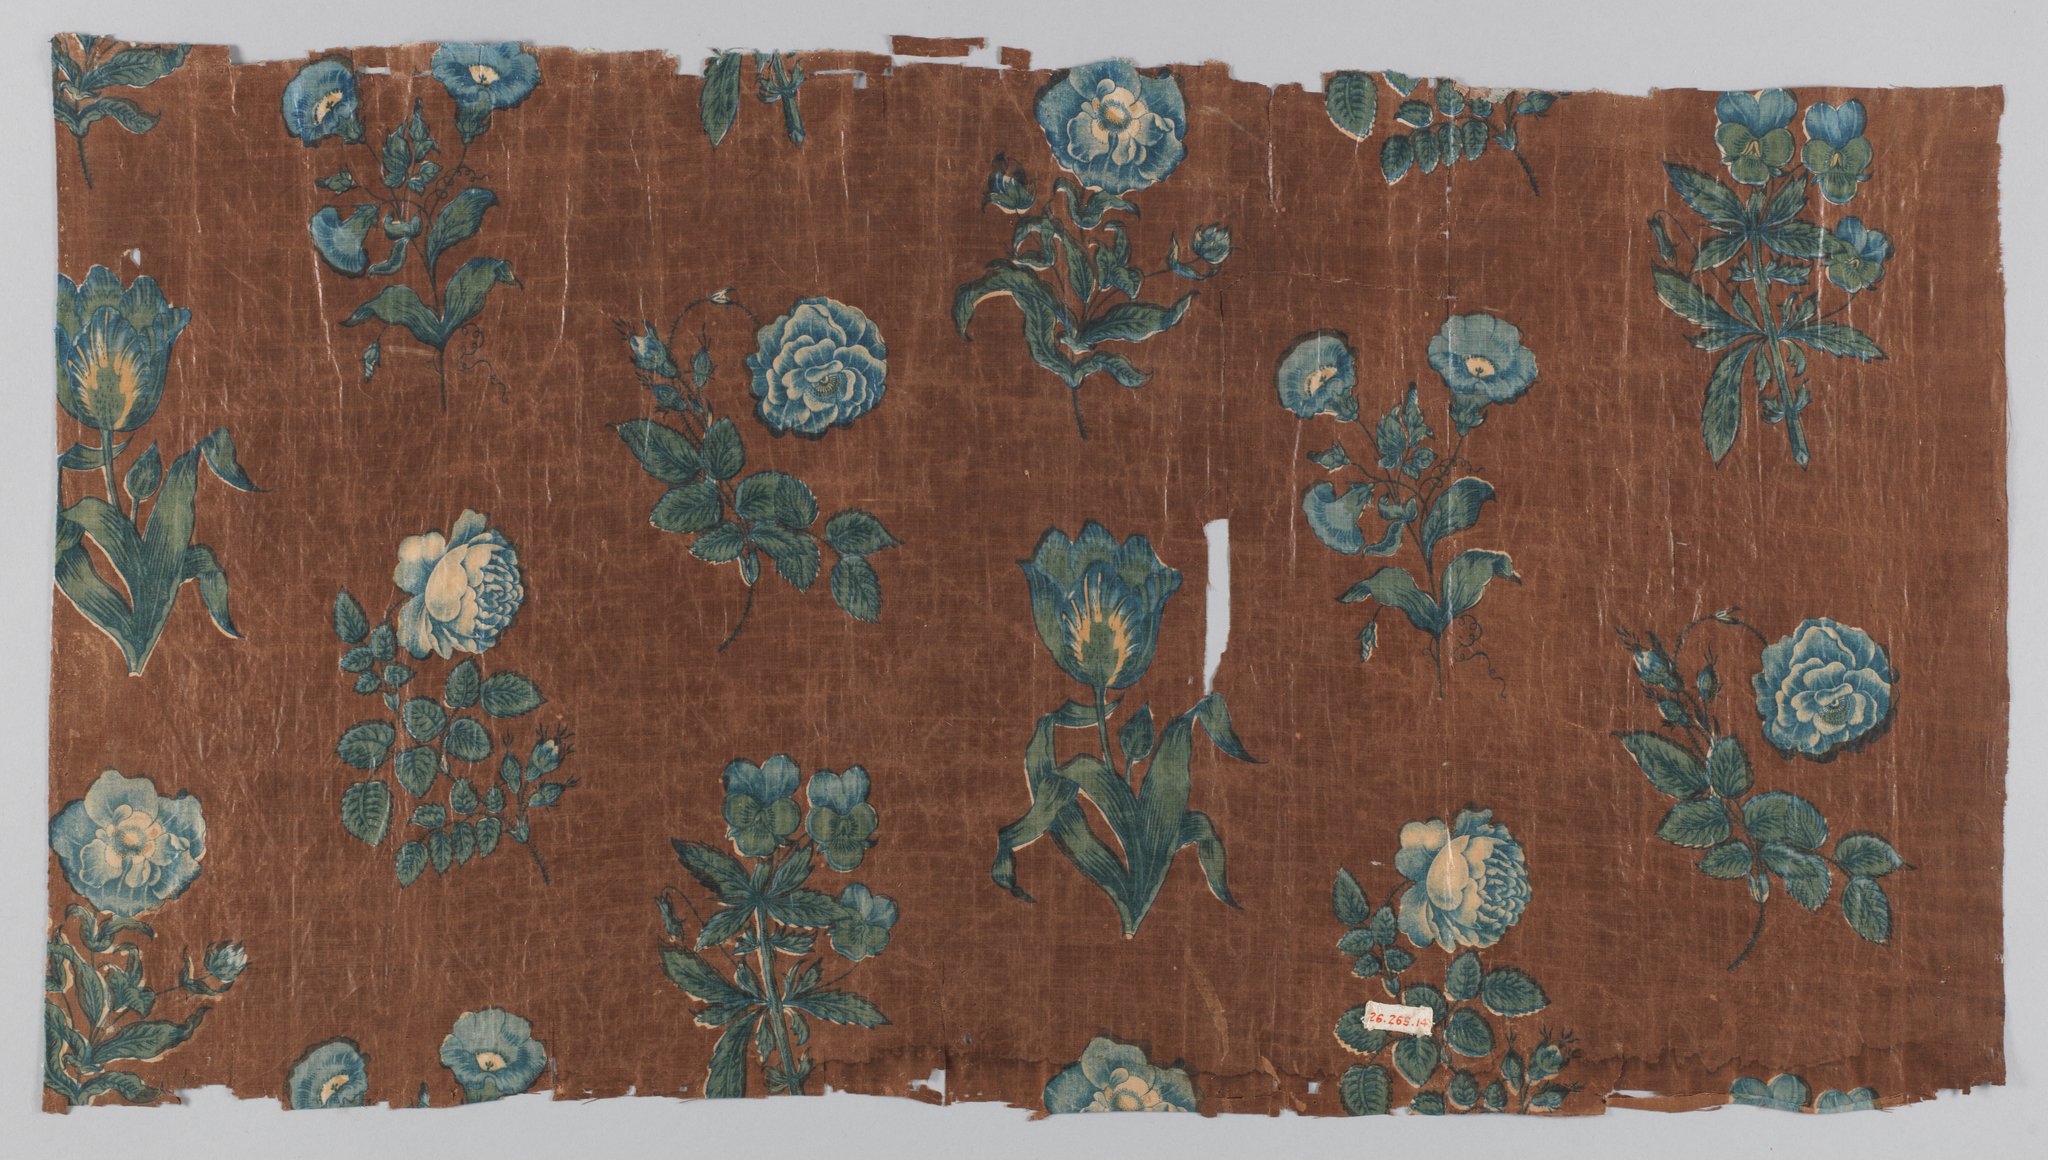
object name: piece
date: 1851-1872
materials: cotton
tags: flowers